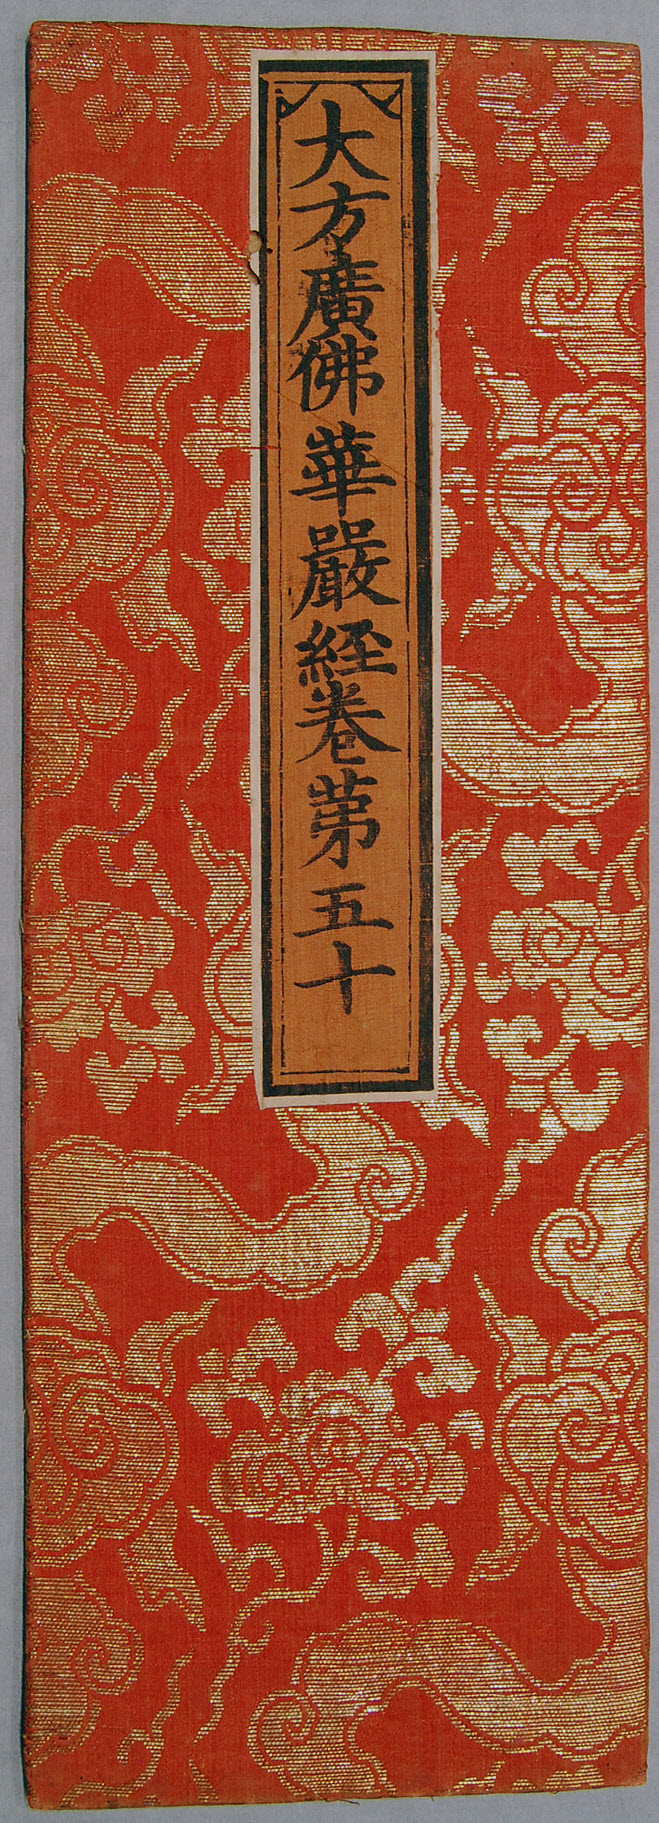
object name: sutra cover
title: Sutra Cover with Lingzhi Fungus and Diagonal Cloud Bands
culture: chinese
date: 1501-1600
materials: metal thread, silk